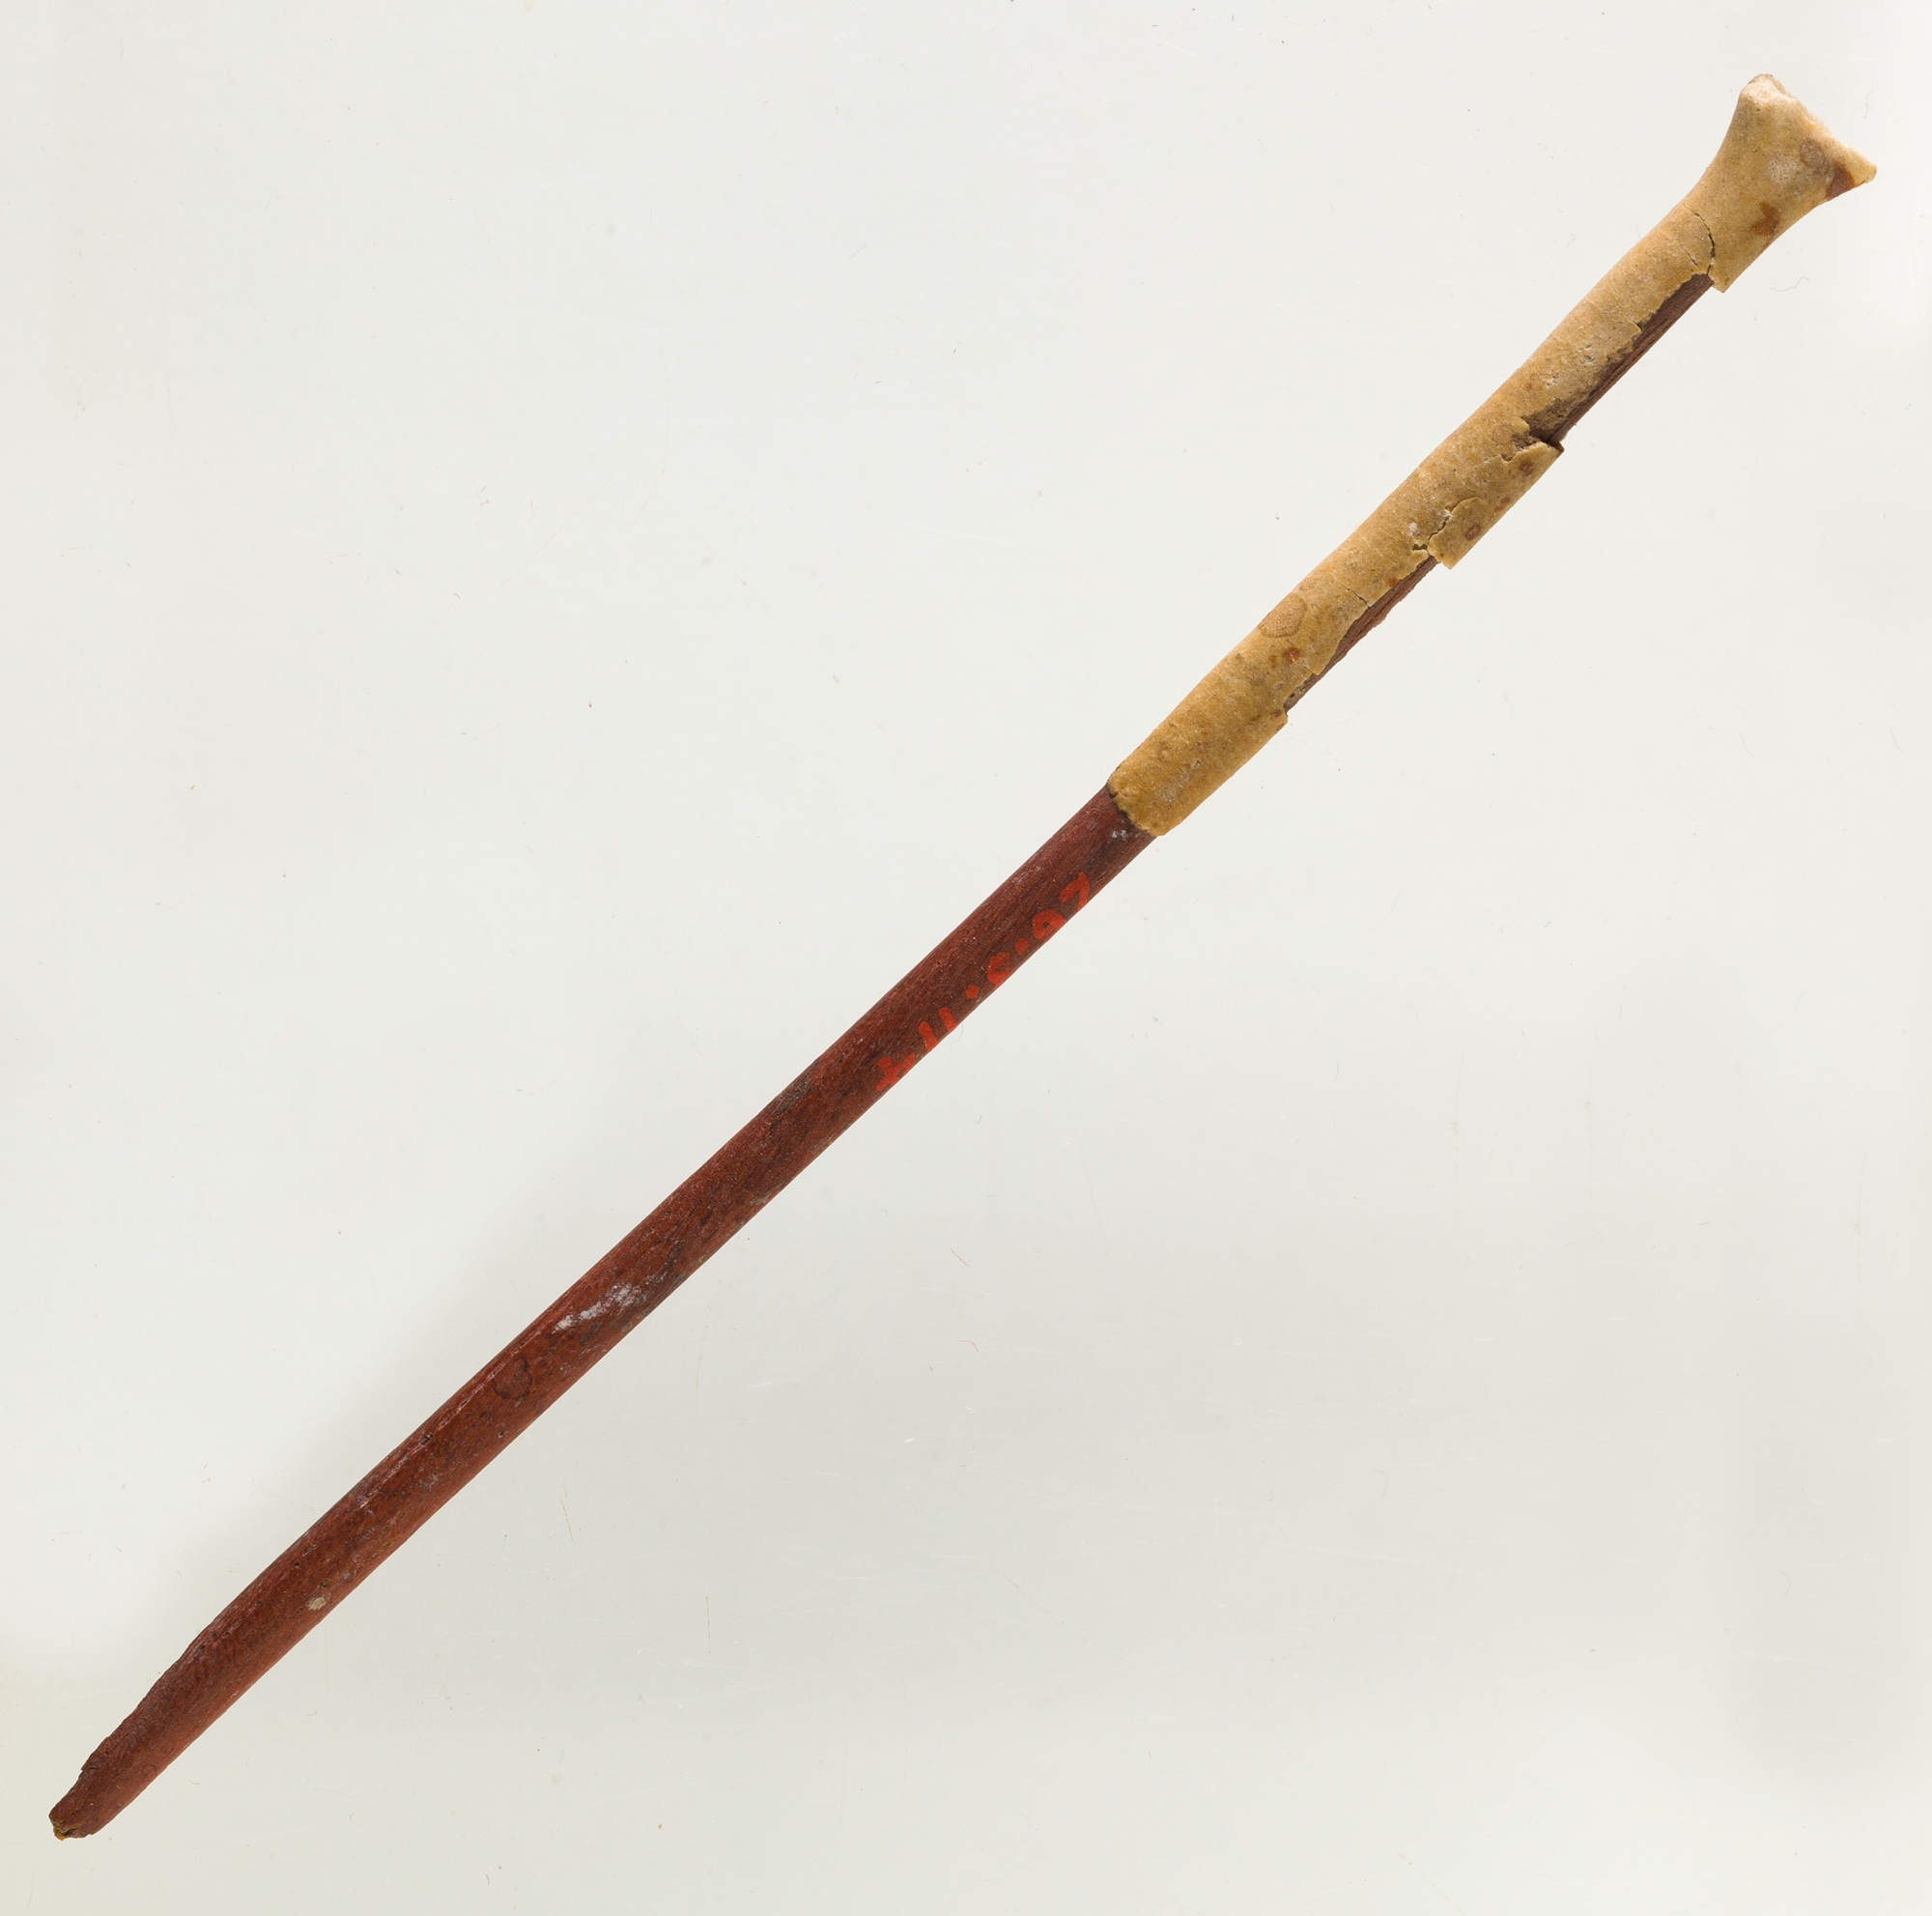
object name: arrow tip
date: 2051-2000 BCE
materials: wood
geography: egypt